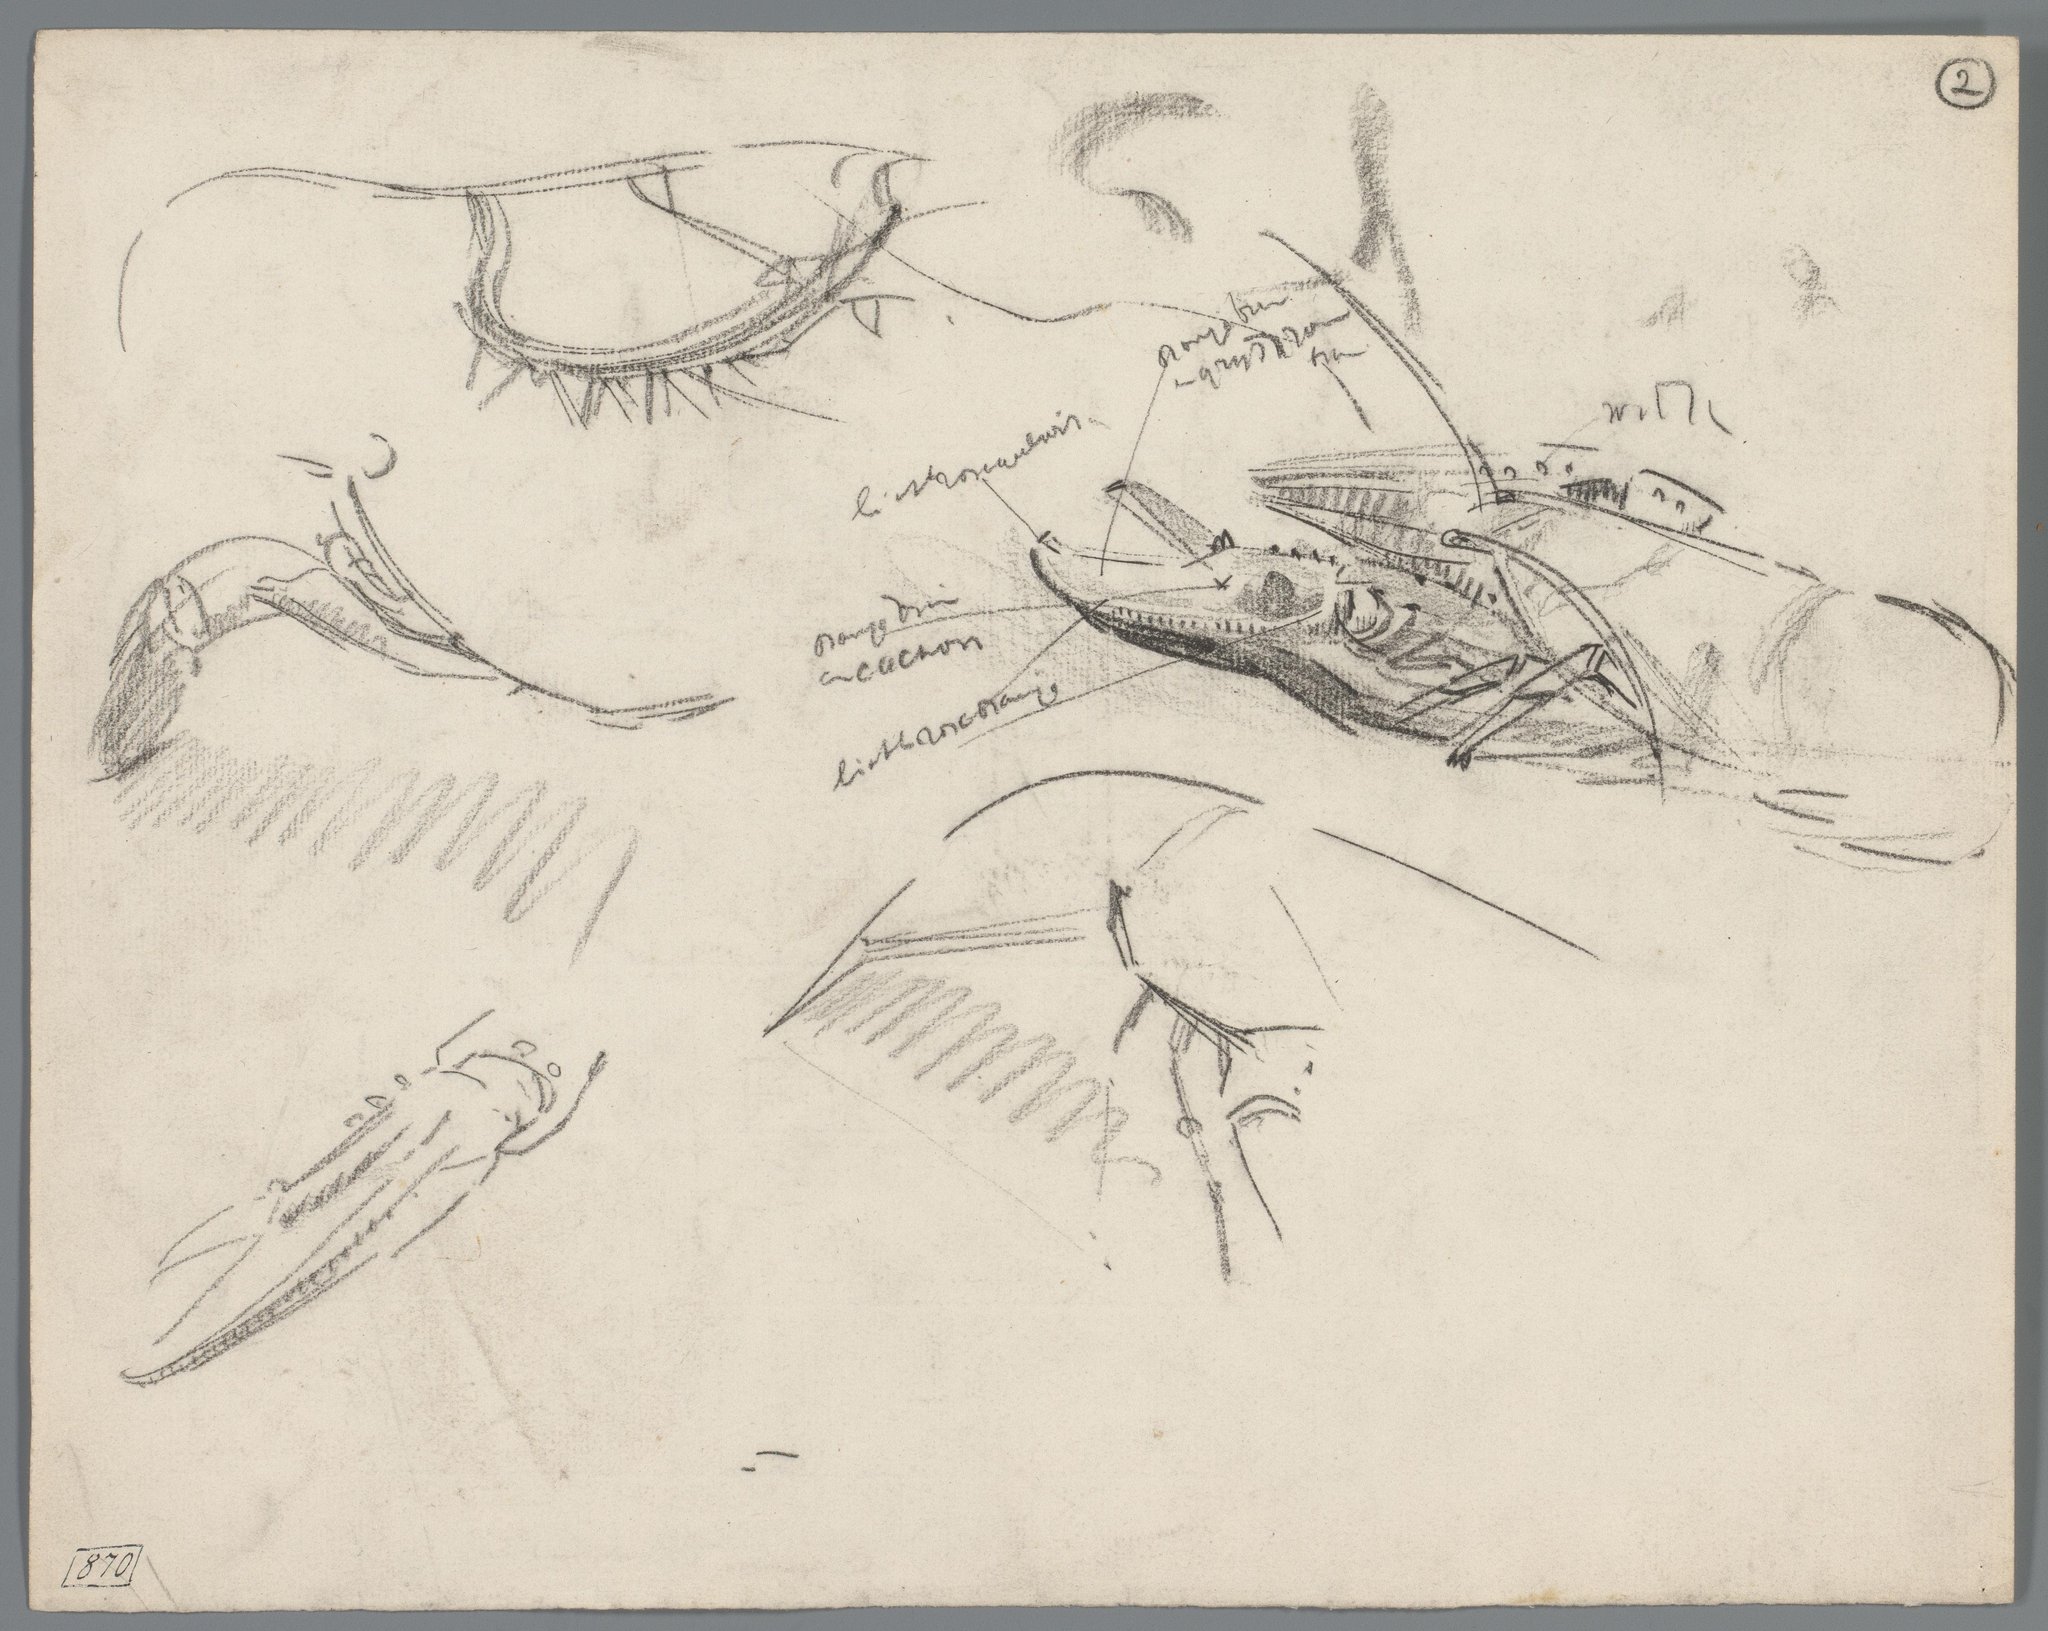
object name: drawing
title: Studies van de scharen en het pantser van kreeften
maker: gerrit willem dijsselhof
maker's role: designer, draughtsman, print maker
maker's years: 1866-1924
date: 1876-1924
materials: chalk, paper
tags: crustaceans: lobster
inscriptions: number: ‘2’, watermark, number: ‘870’